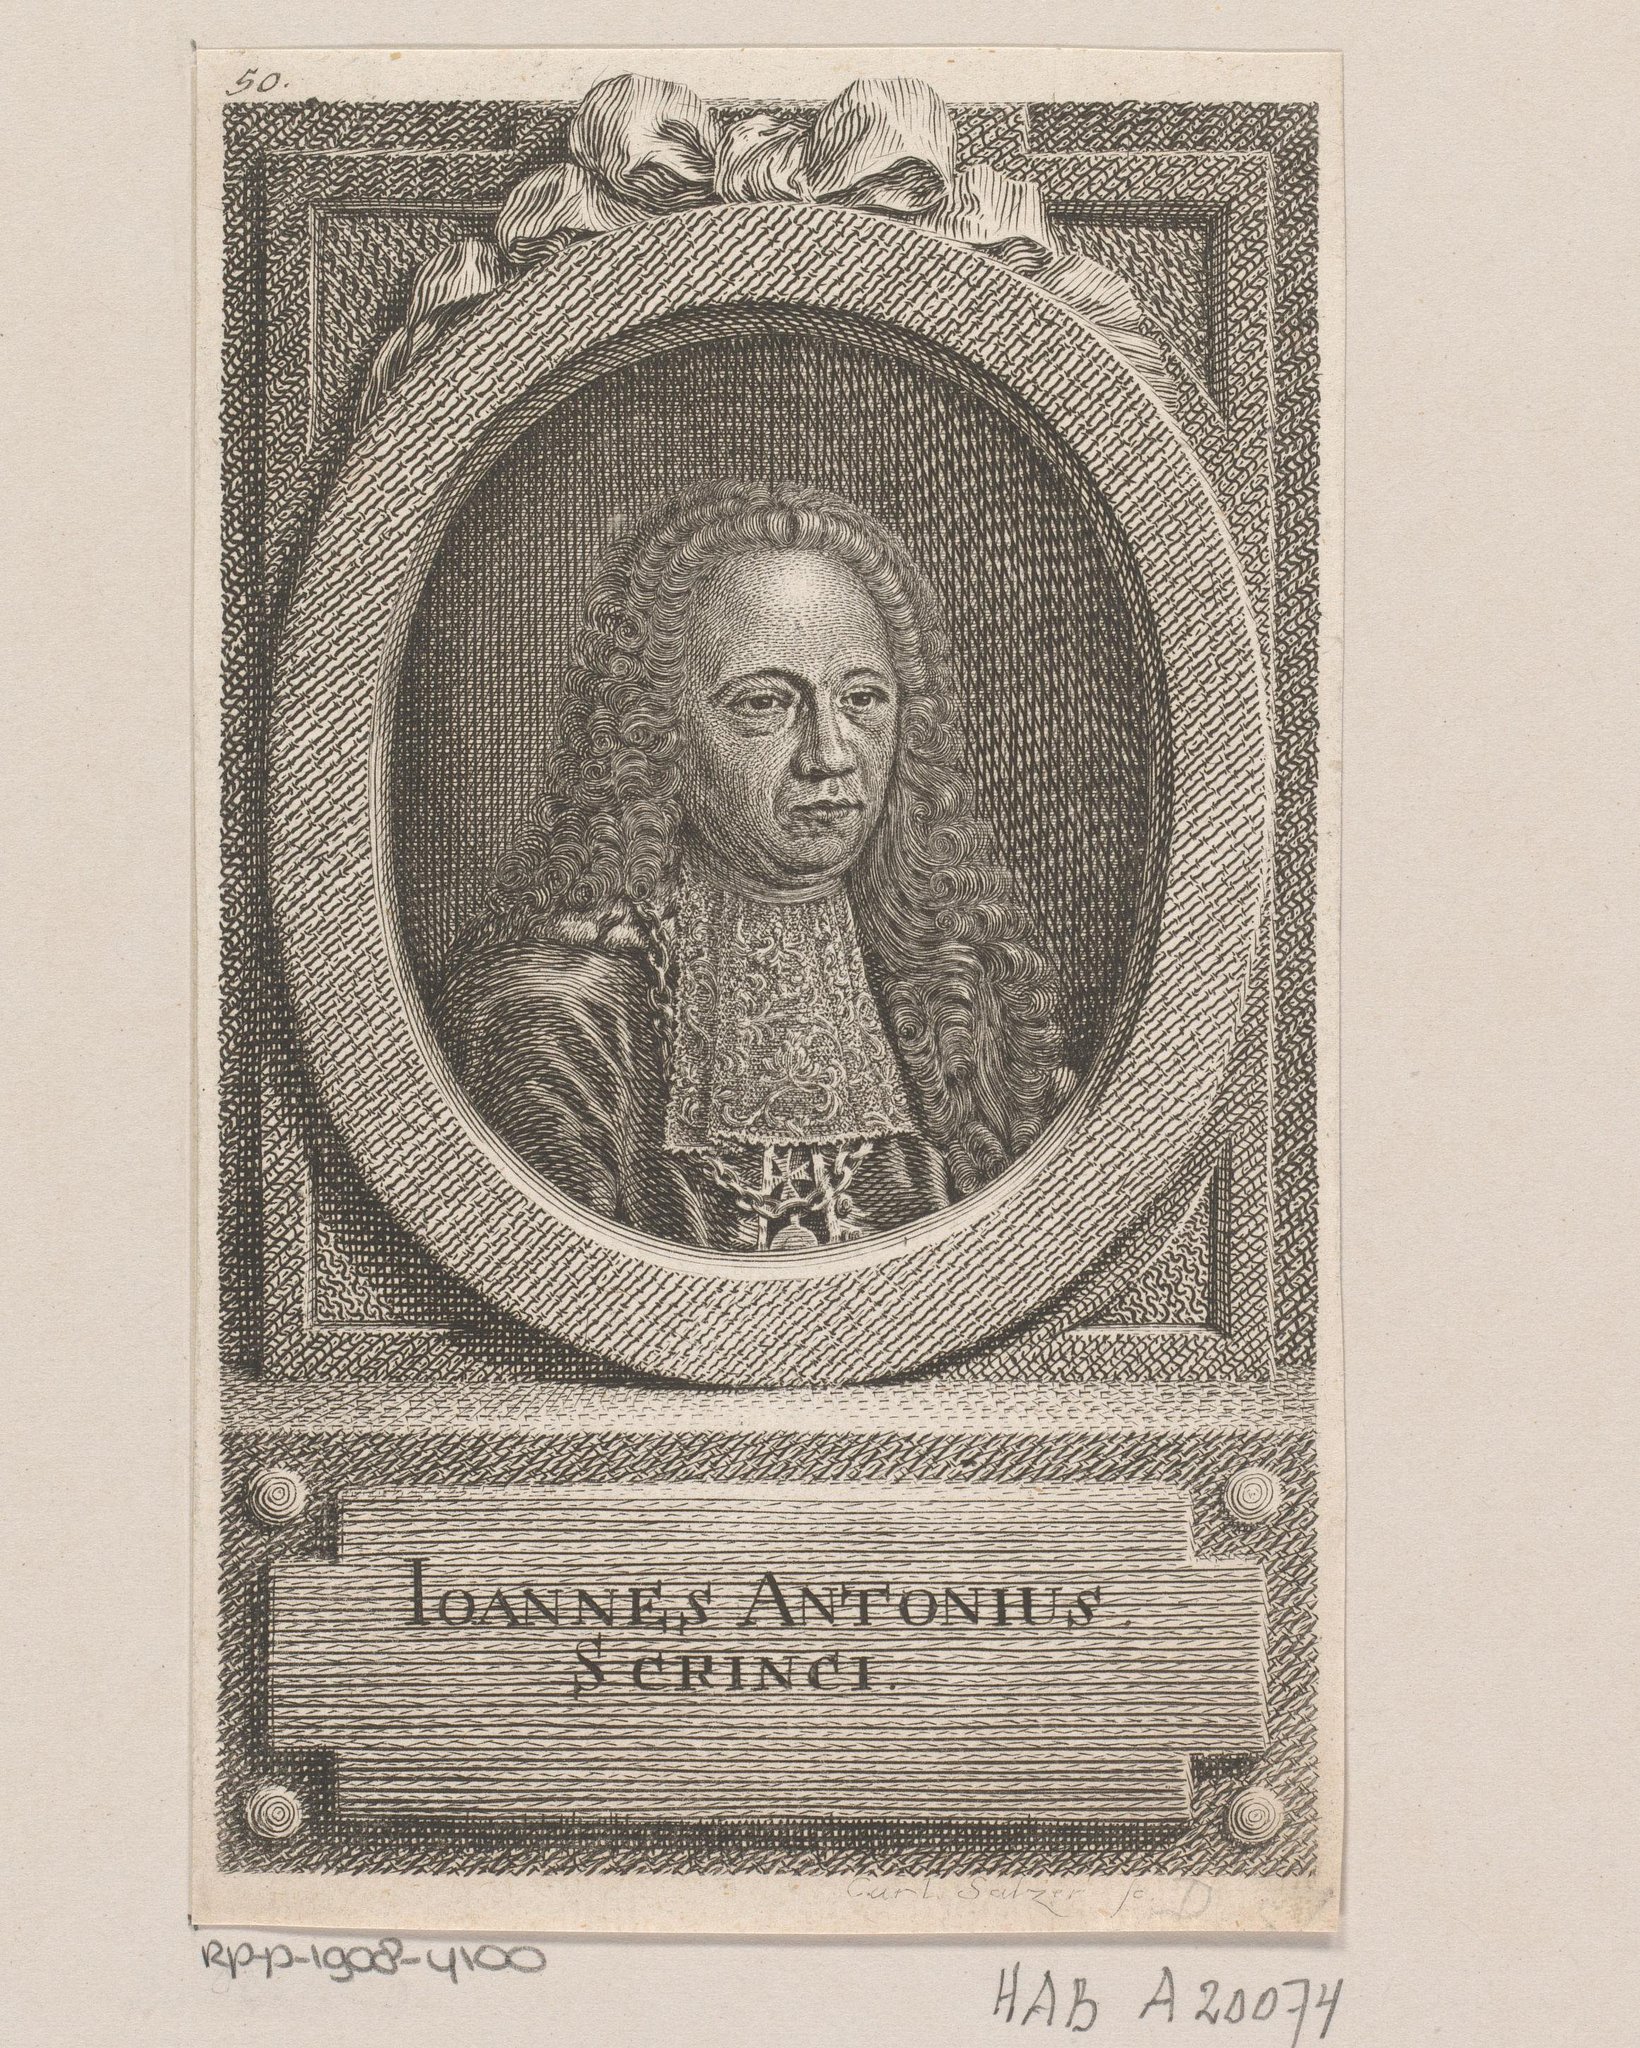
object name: print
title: Portret van Johann Anton Joseph Scrinci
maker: carl salzer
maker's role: print maker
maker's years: 1740-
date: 1772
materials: paper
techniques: engraving, etching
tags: prague, historical persons, physician, doctor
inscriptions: collector's mark: Lugt 2228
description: Prent waarschijnlijk uit: Balzer, Johann. 87 Abbildungen Böhmischer und Mährischer Gelehrten und Künstler. Praag: s.n., [1772].